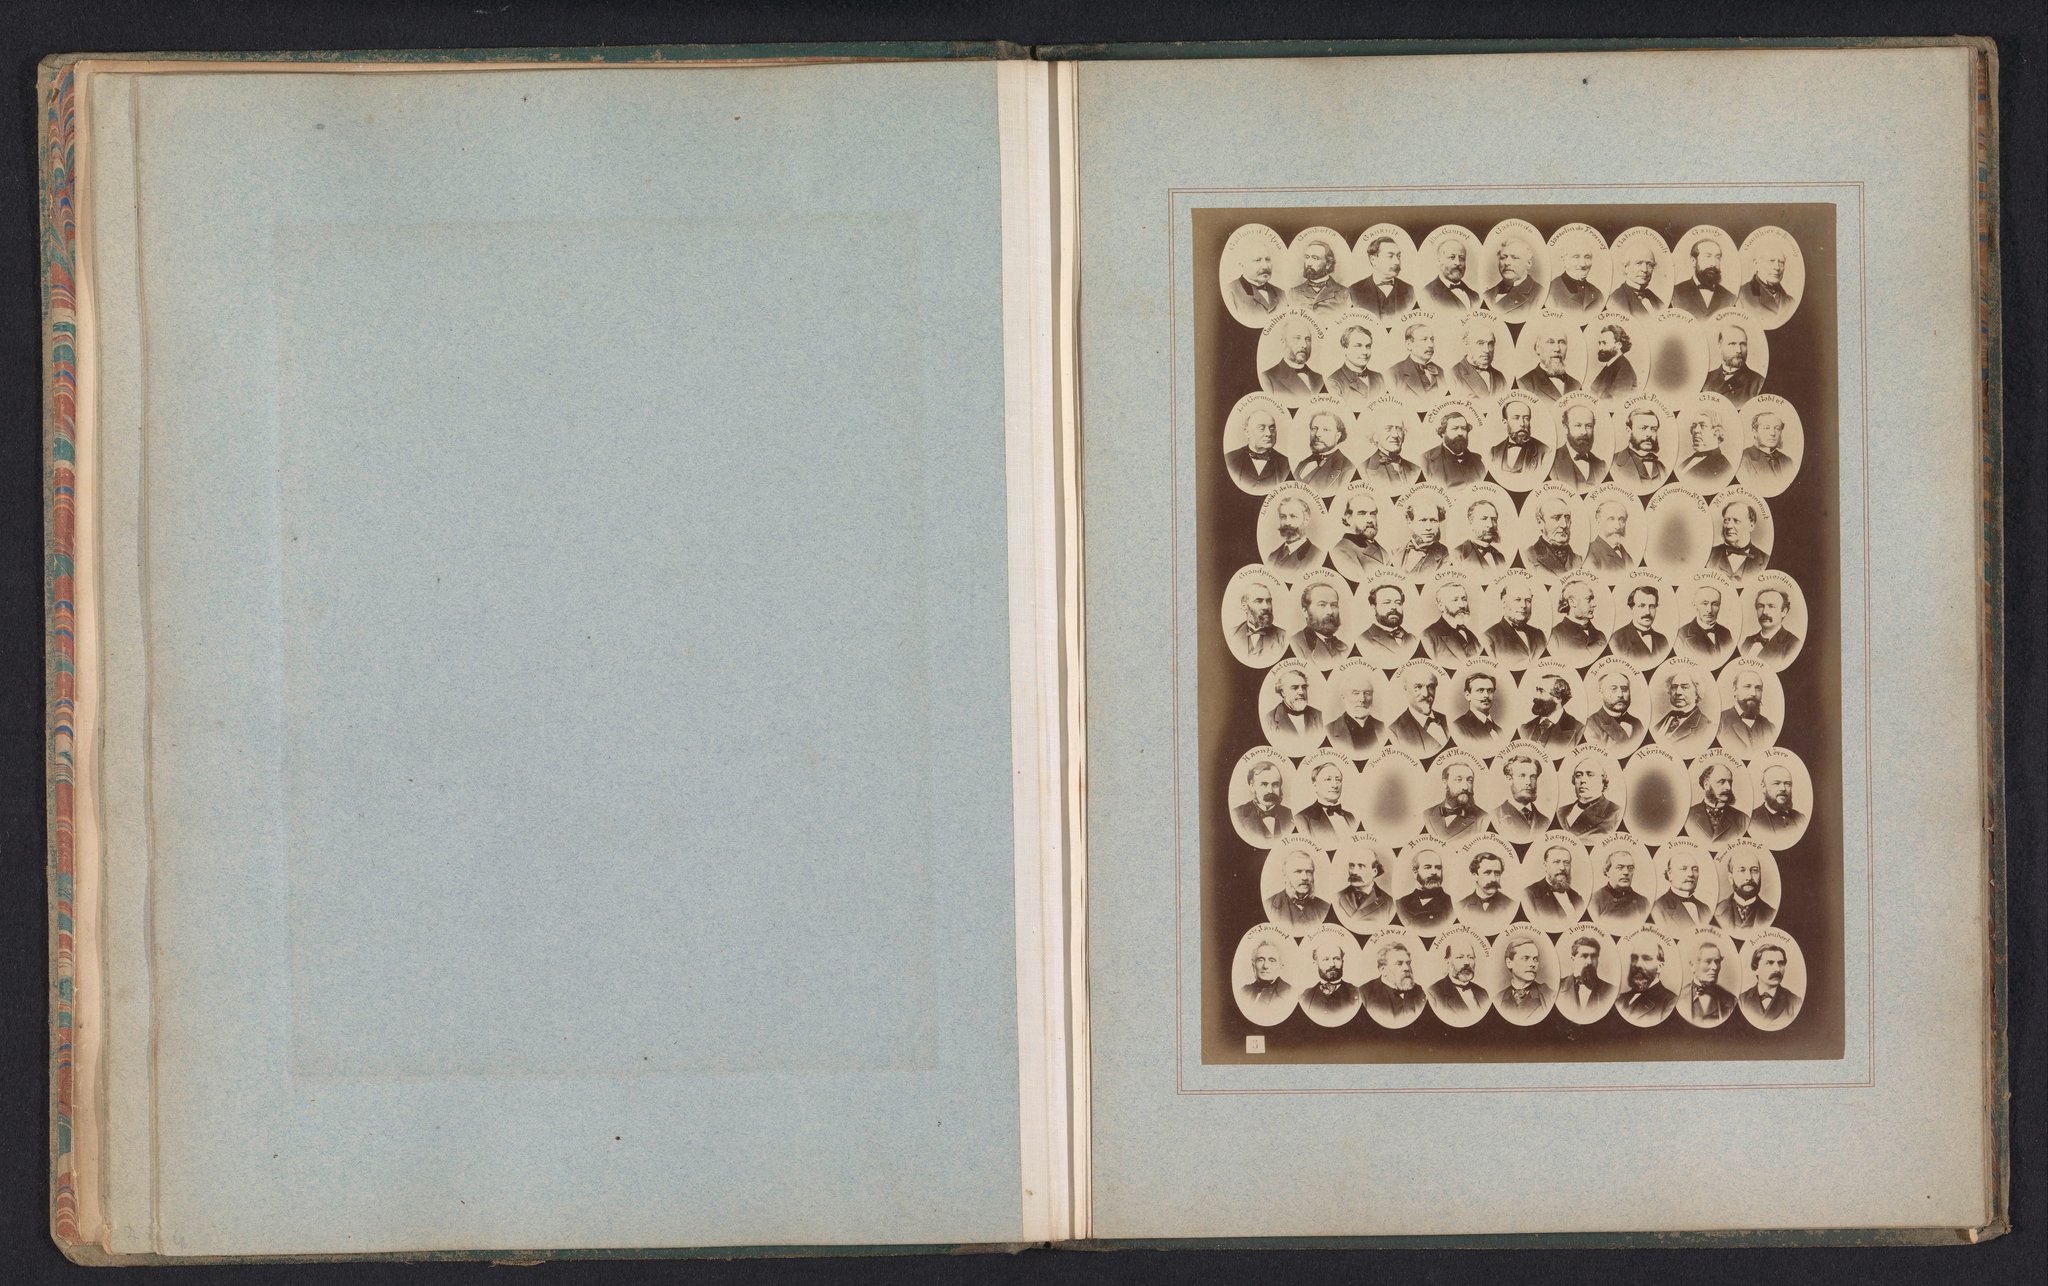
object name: page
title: Samengesteld groepsportret van leden van de Assembée Nationale van 1874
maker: françois marie louis franck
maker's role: fotograaf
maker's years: 1816-1906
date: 1872-1875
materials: photographic support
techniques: albumen print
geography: france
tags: politician, e.g. party leader, lower house, parliament, chamber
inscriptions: number: ‘5’